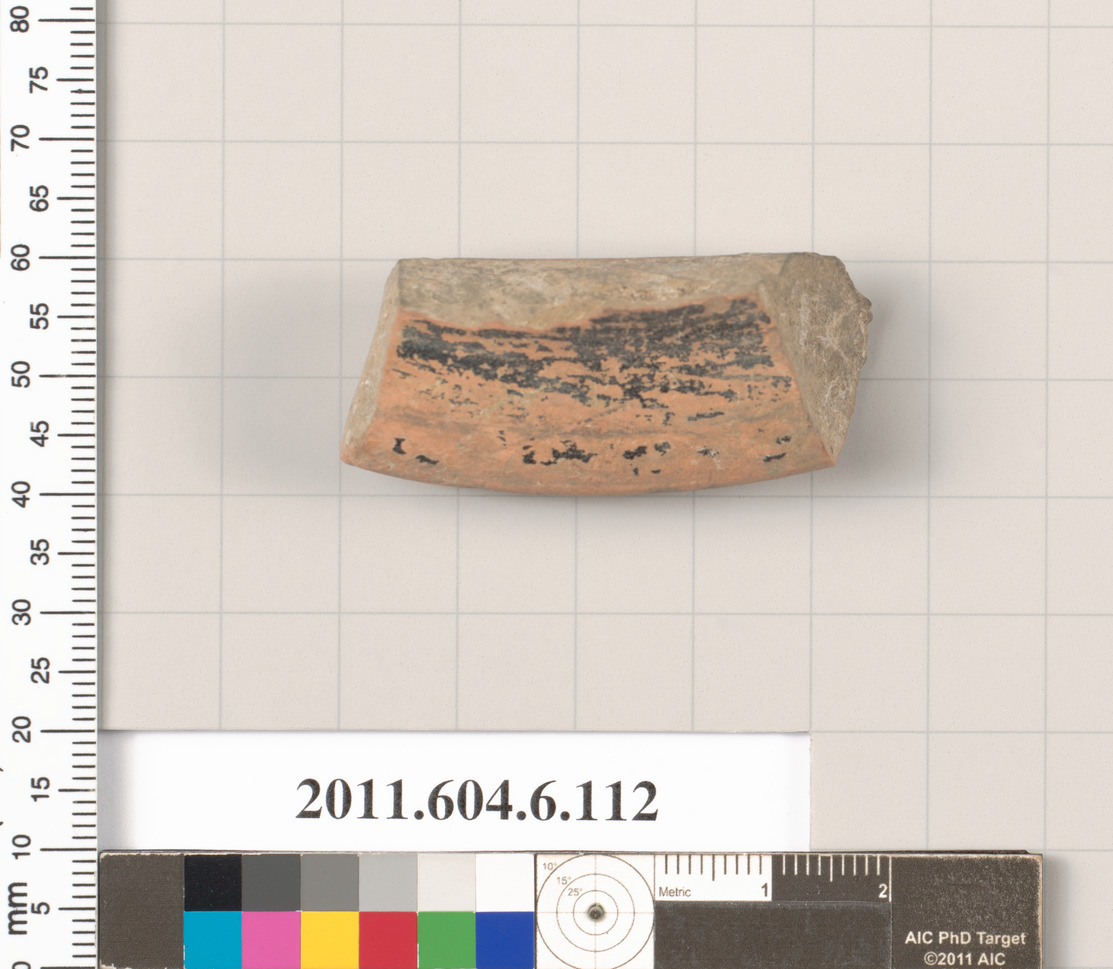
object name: undetermined shape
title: Terracotta fragment of an undetermined shape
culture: greek, attic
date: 600-401 BCE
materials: terracotta